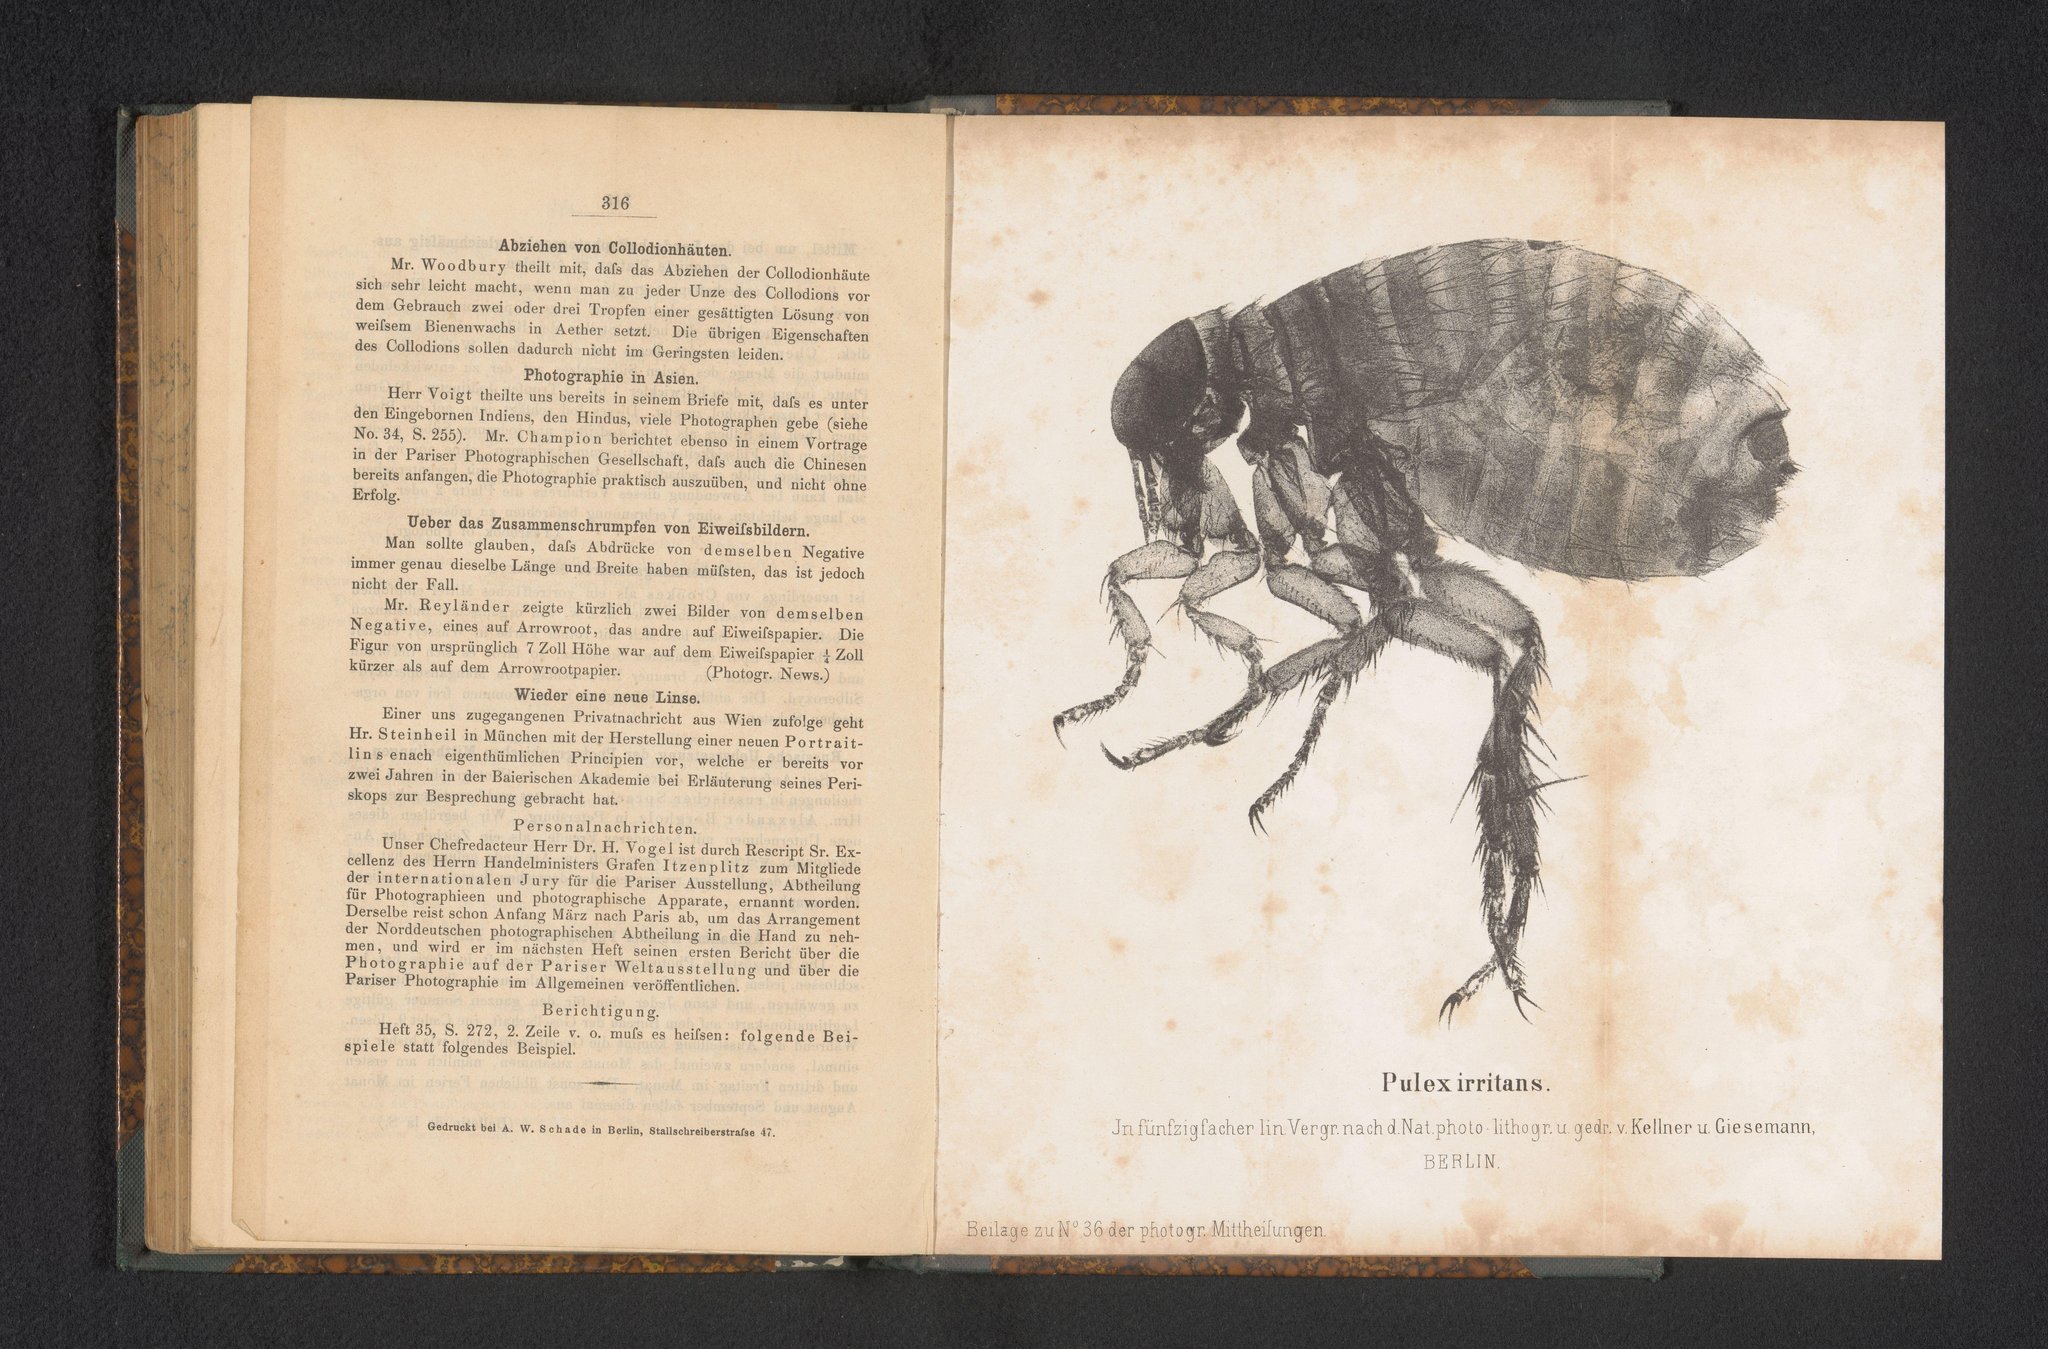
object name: photomechanical print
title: Fotoreproductie van een vergroting van een mensenvlo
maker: Anonymous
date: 1862-1867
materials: paper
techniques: photolithography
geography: berlin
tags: insects: flea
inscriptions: inscription: ‘Beilage zu No 36 der photogr. Mittheilungen.’